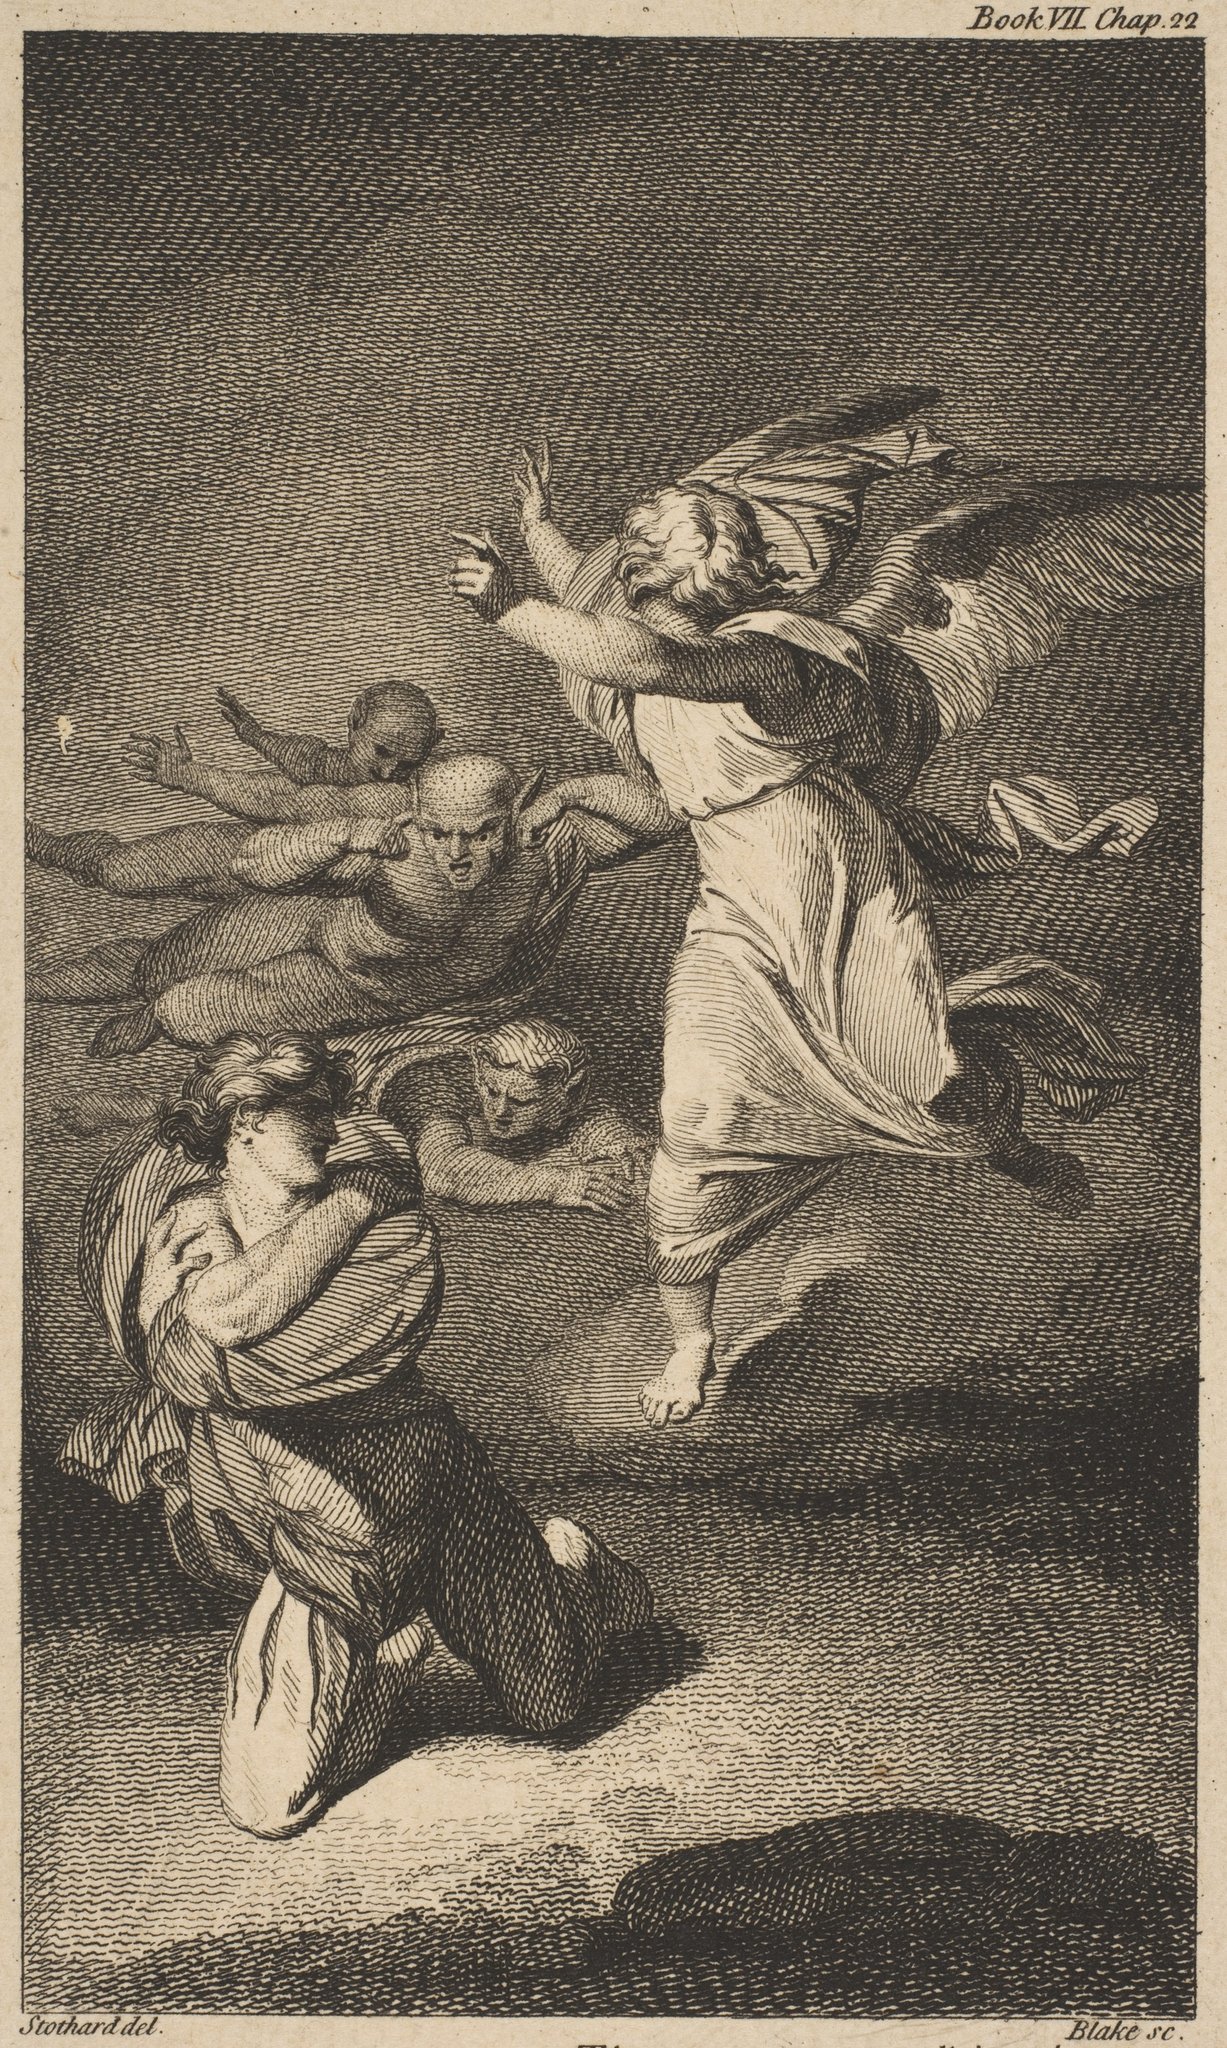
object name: print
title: Clarence's Dream (Shakespeare, Richard III, Act 1, Scene 4)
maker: william blake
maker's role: artist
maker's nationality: british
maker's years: 1757-1827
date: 1774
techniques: engraving, etching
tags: shakespeare,men